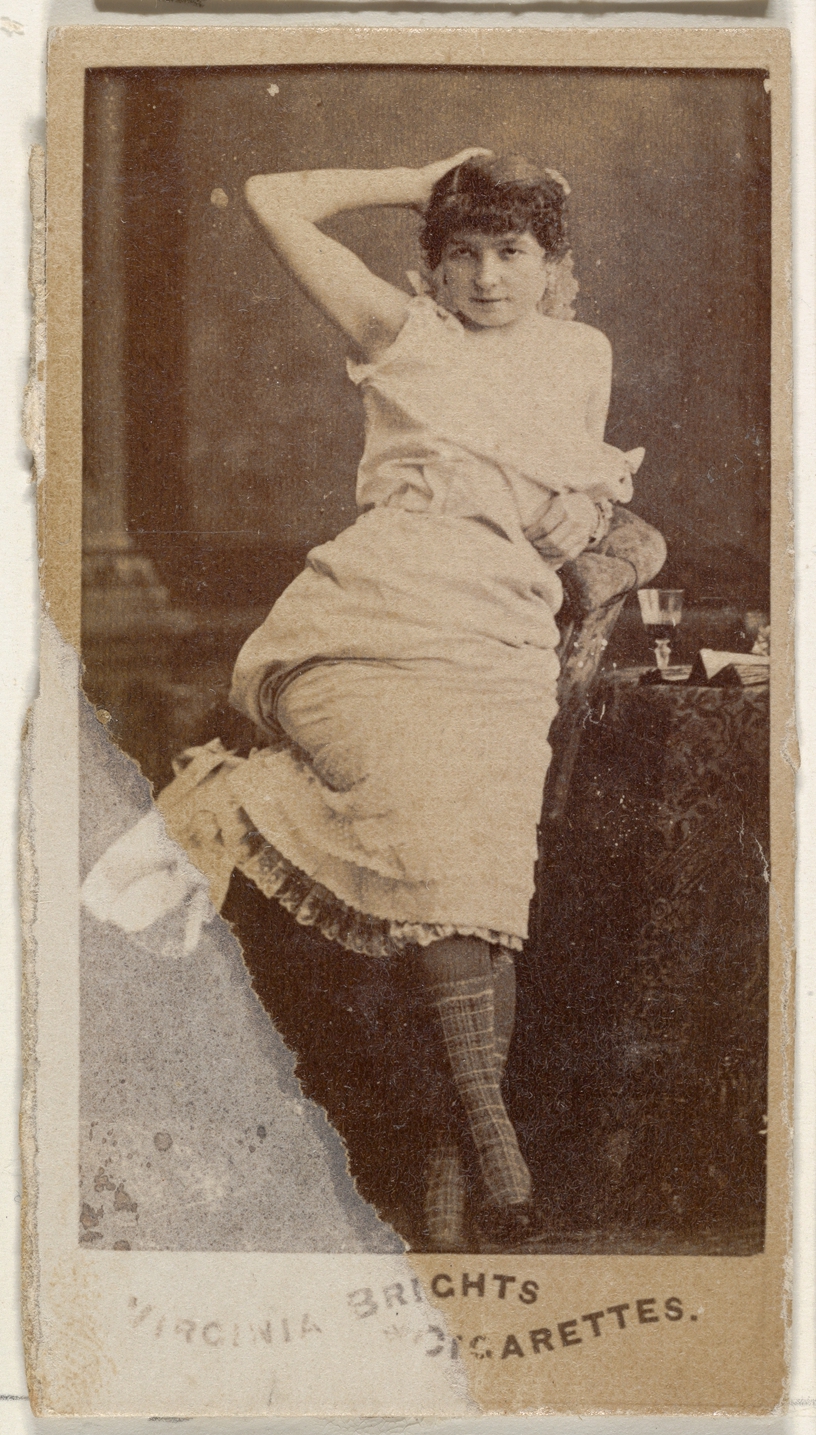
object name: photograph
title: From the Actors and Actresses series (N45, Type 5) for Virginia Brights Cigarettes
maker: allen & ginter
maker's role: publisher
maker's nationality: american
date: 1888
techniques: albumen silver print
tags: portraits,women,actresses